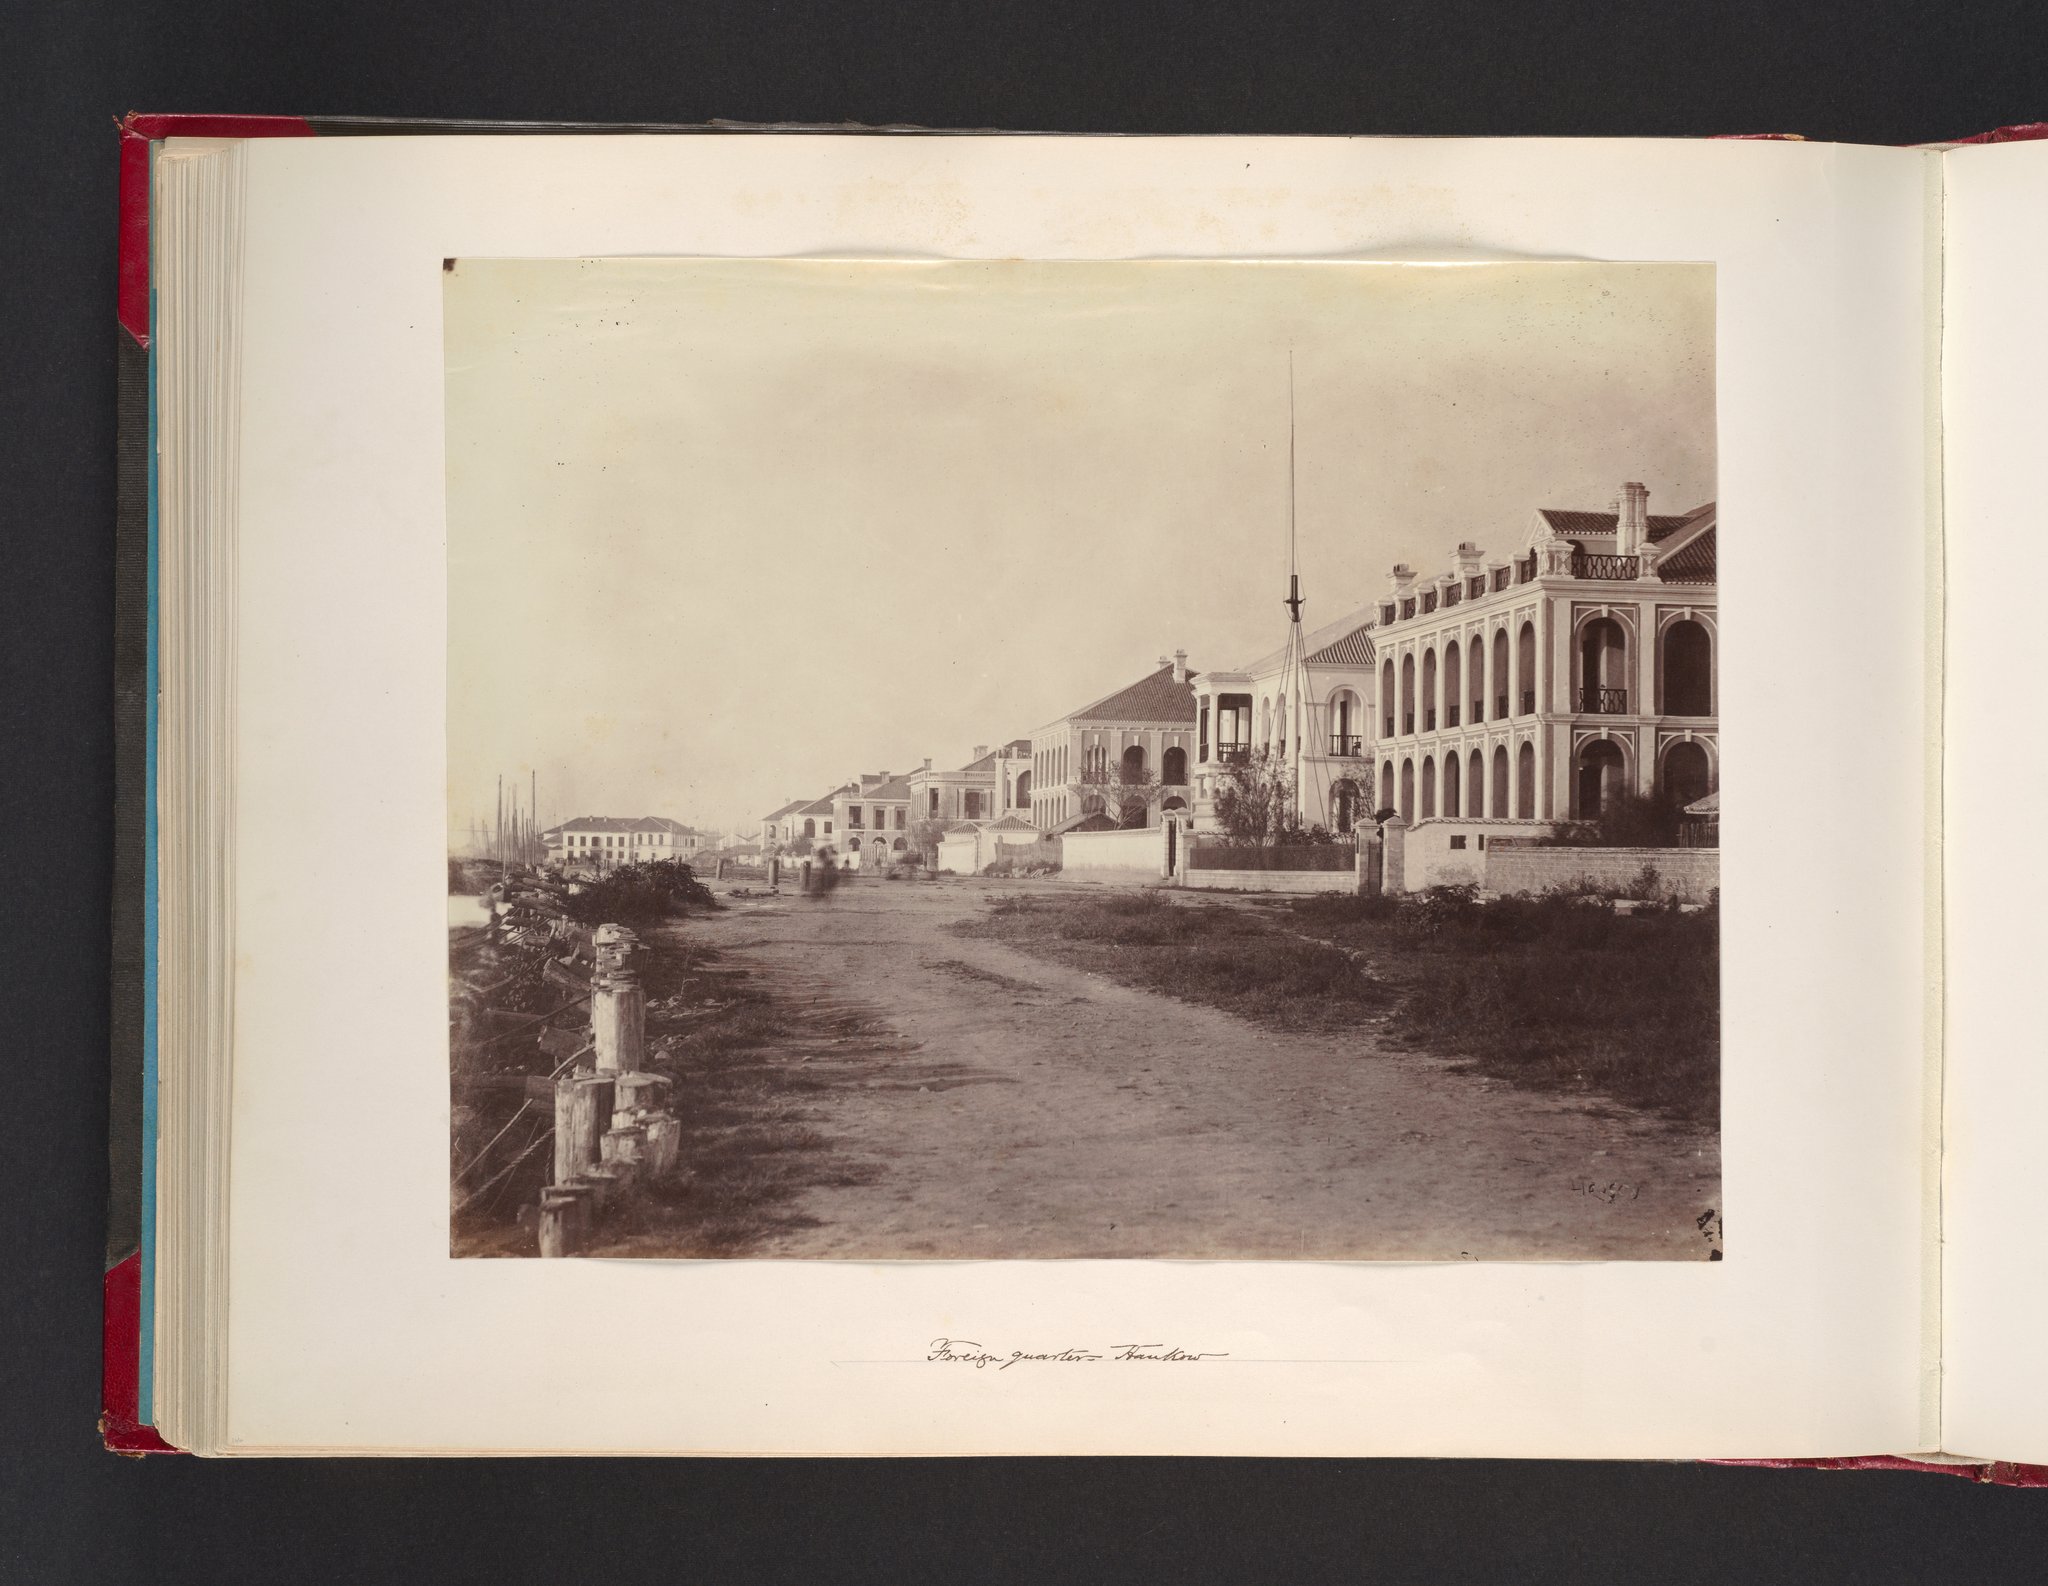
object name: photograph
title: Foreign Quarter. Hankow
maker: john thomson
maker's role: artist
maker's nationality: british, scottish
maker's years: 1837-1921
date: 1865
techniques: albumen silver print, glass negative